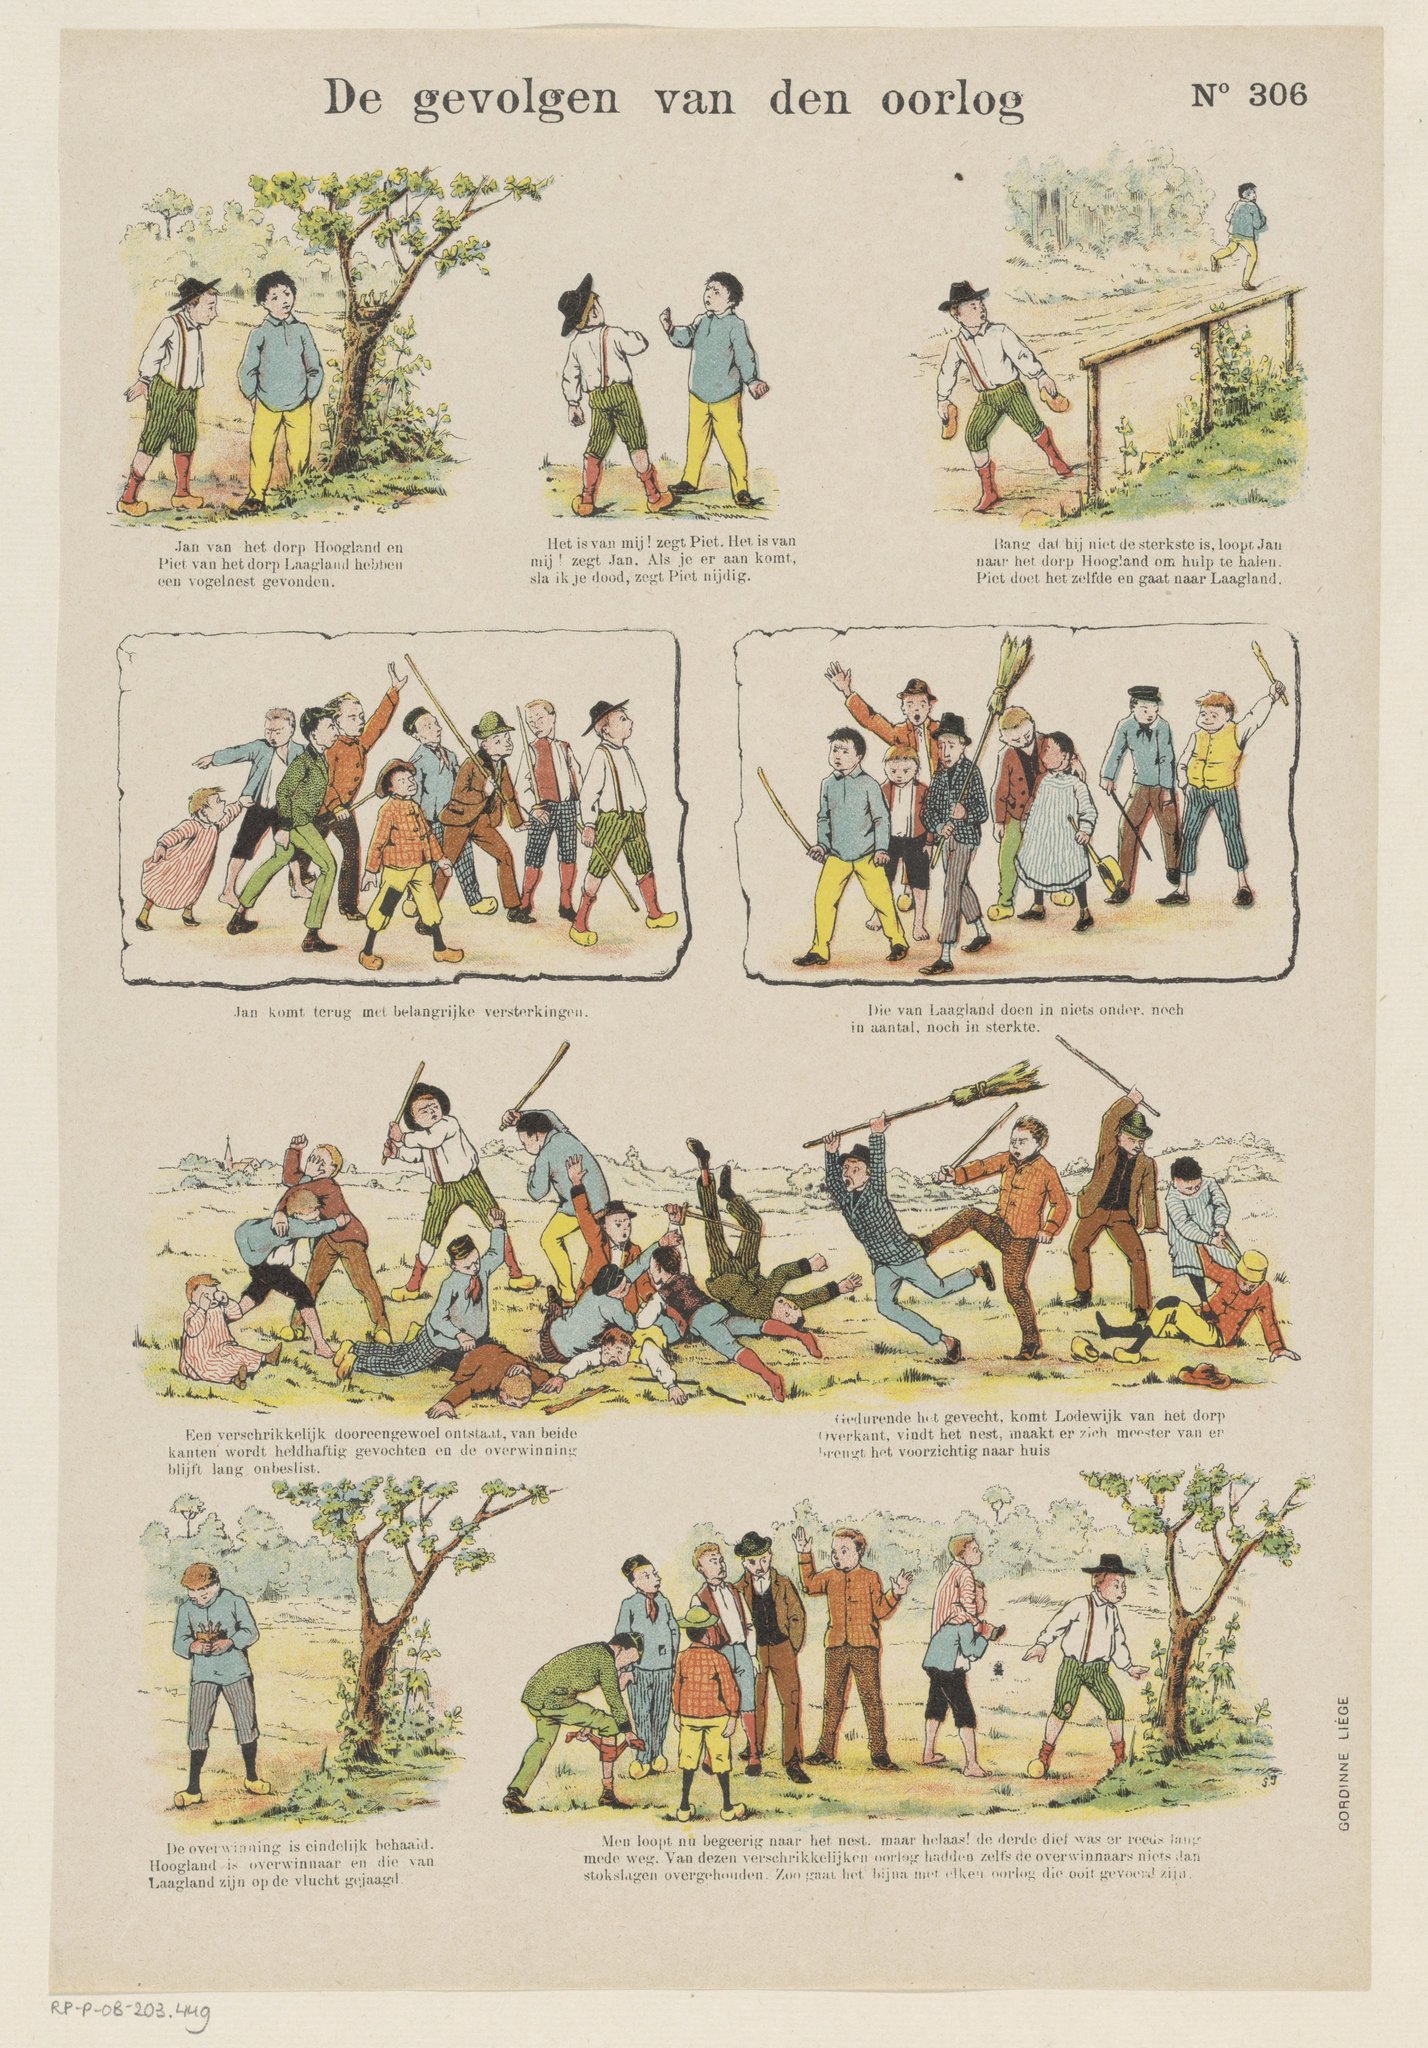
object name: print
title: De gevolgen van den oorlog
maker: Anonymous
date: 1894-1959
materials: paper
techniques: lithograph, letterpress printing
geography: liège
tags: rough-and-tumble; fighting, child robbing bird's nests, child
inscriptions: collector's mark: Lugt 2760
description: Blad met 8 voorstellingen over twee groepen kinderen die vechten om een vogelnest, terwijl een derde partij er stiekem mee vandoor gaat. Onder elke afbeelding een onderschrift. Genummerd rechtsboven: No 306.